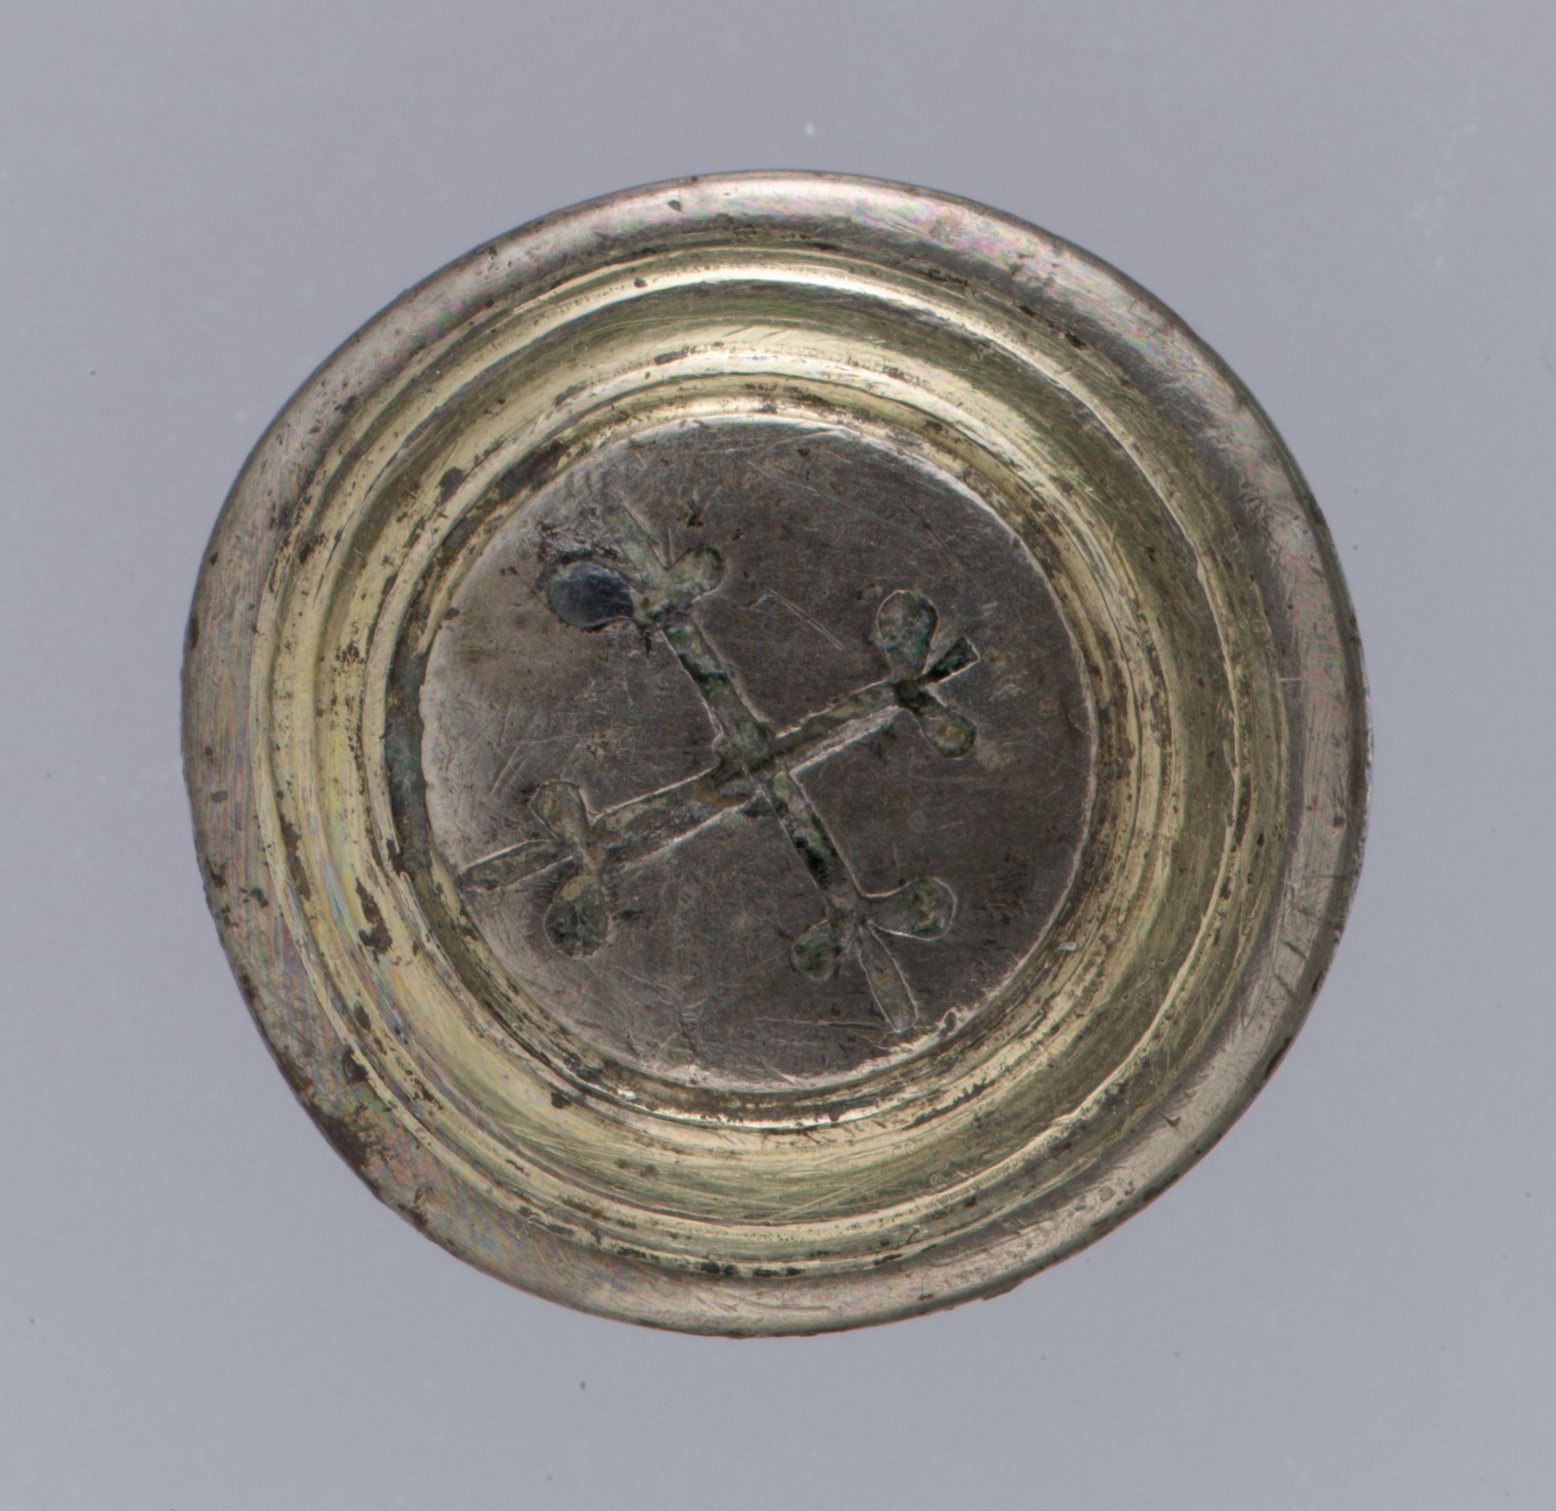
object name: terminal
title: Disk terminal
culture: roman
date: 367-433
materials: niello, silver gilt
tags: cross